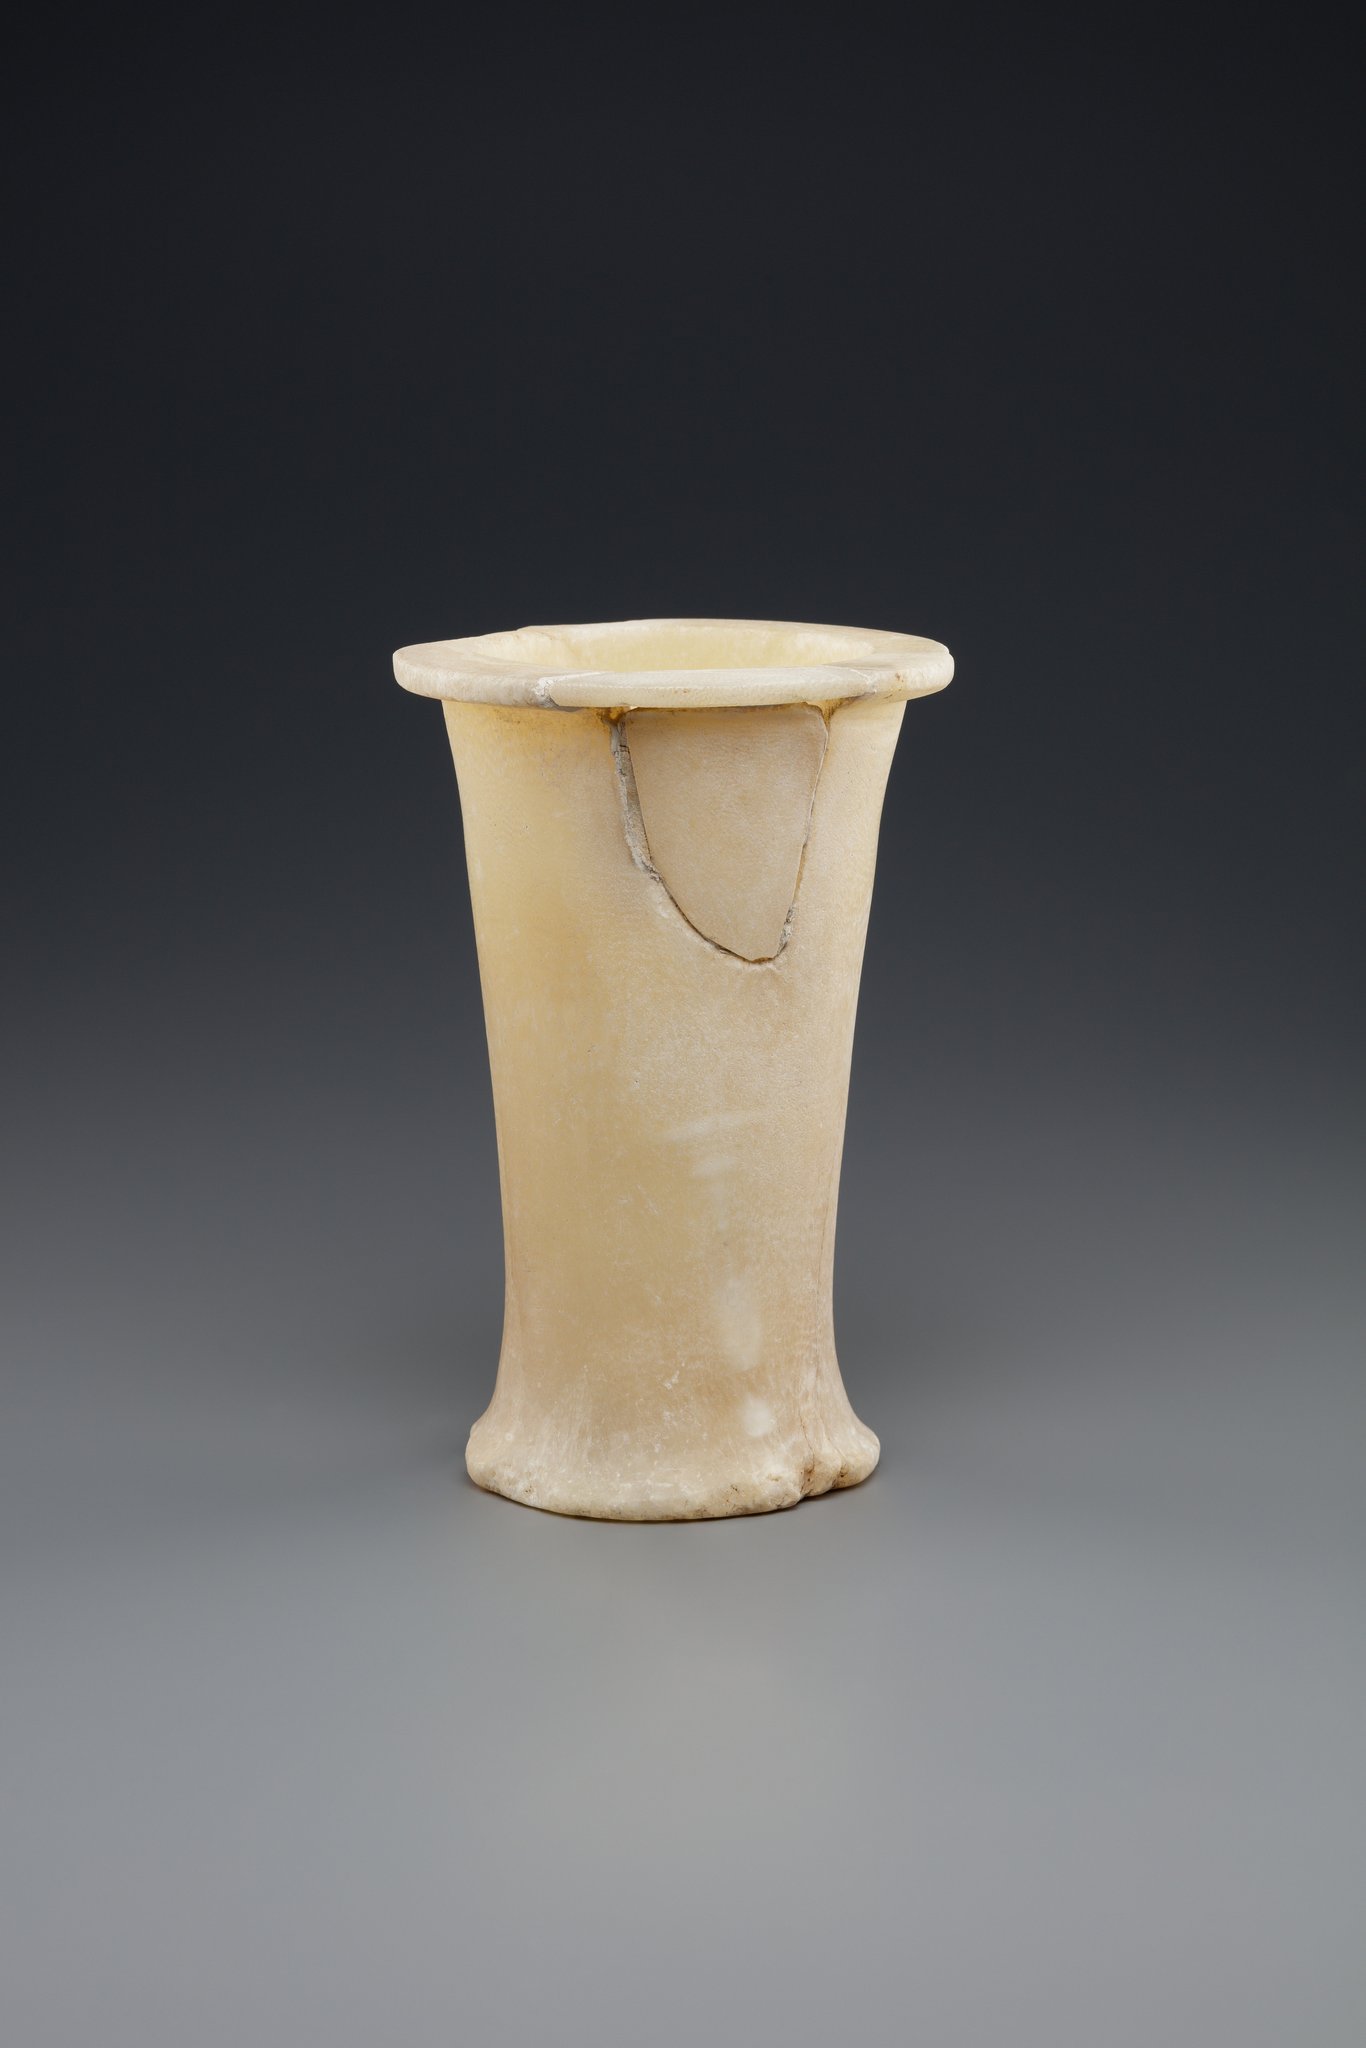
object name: toilet jar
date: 2323-2150 BCE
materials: stone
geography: egypt